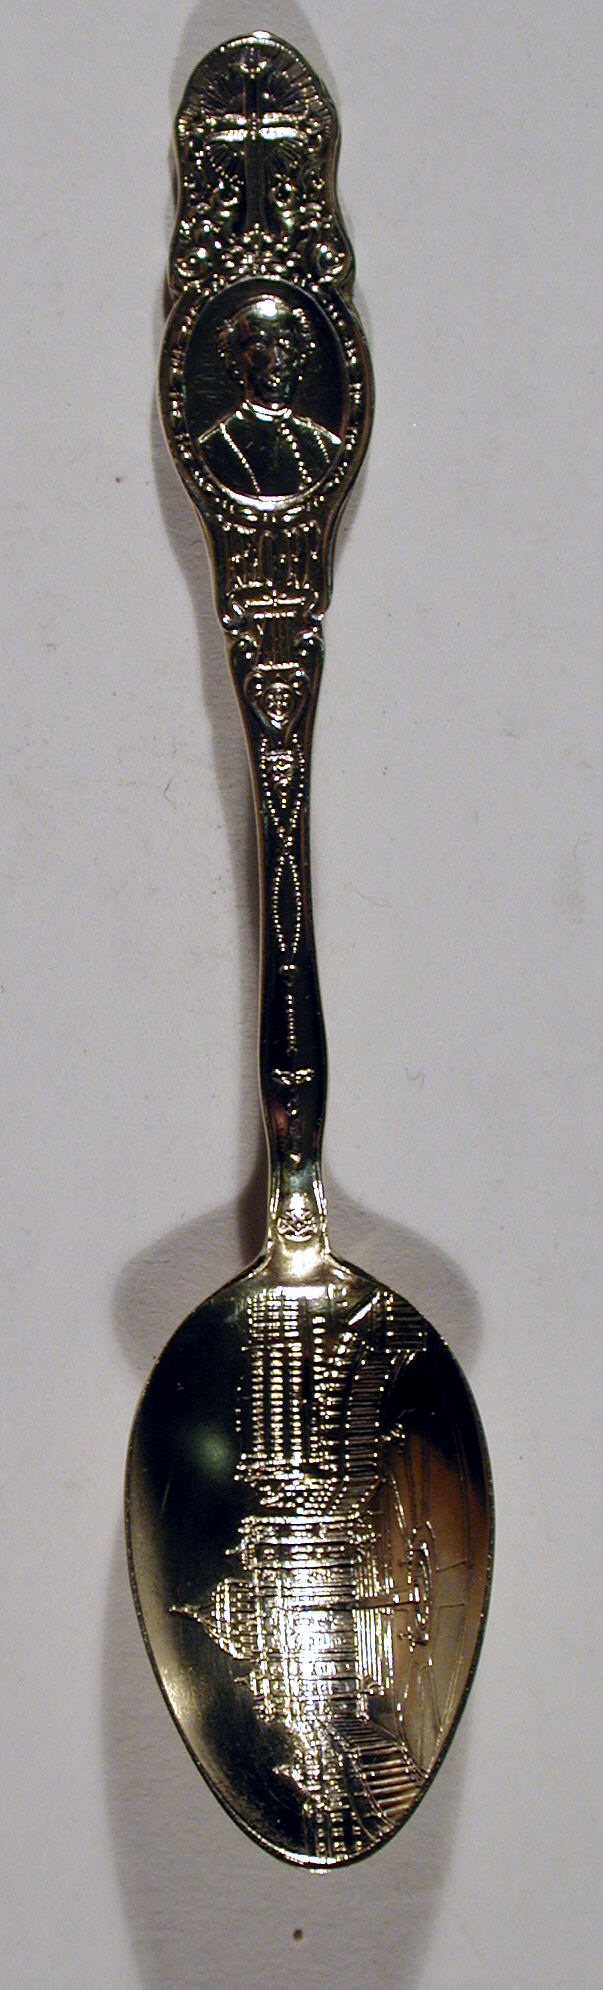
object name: souvenir spoon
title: Souvenir spoon with depiction of St. Peter's Basilica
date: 1867-1900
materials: gilt, silver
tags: churches,men,portraits